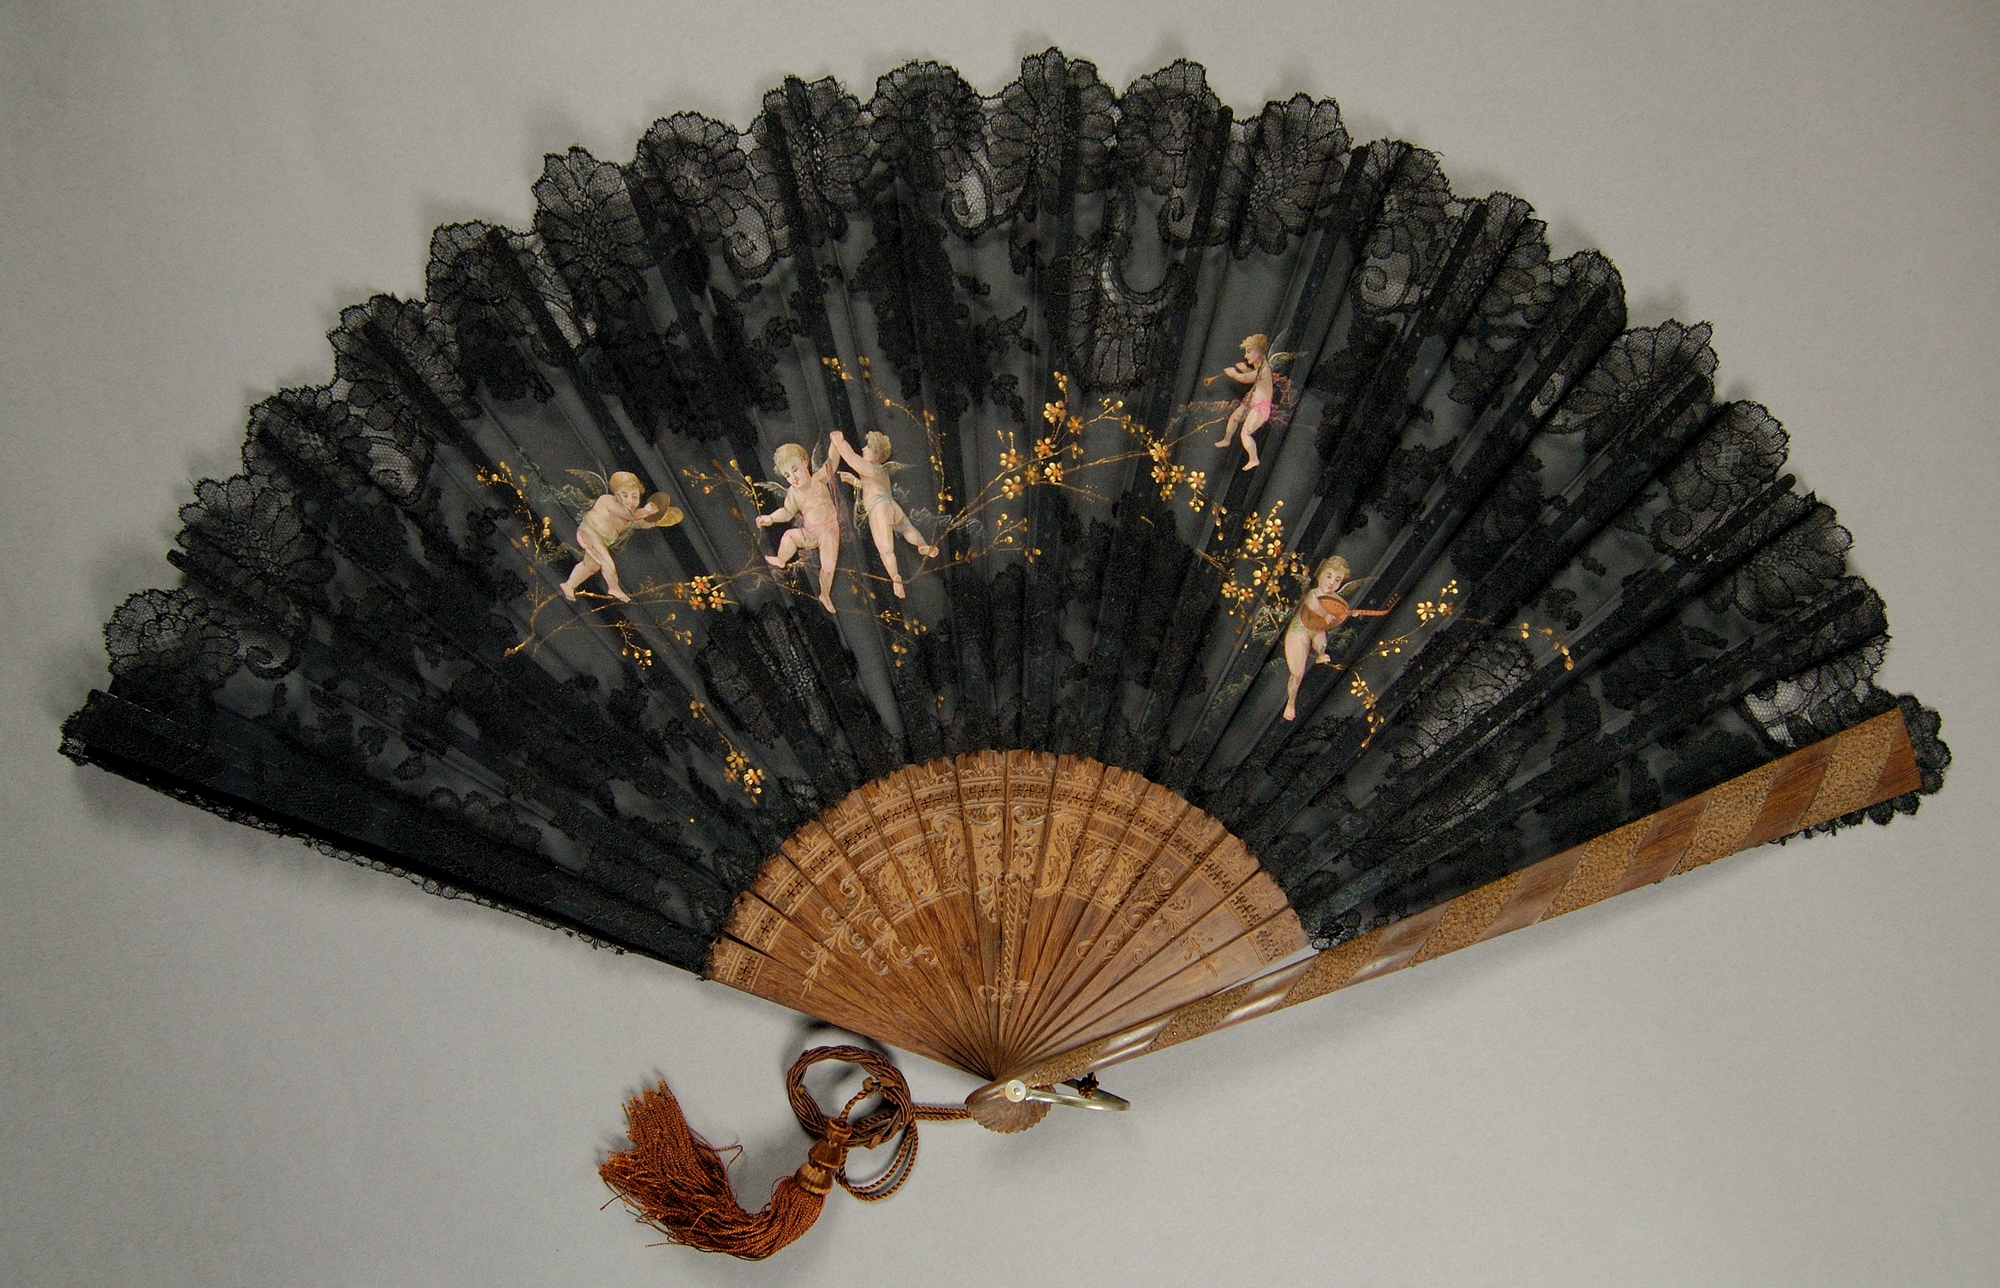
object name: fan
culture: french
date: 1885-1895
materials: metal, mother of pearl, silk, wood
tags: putti